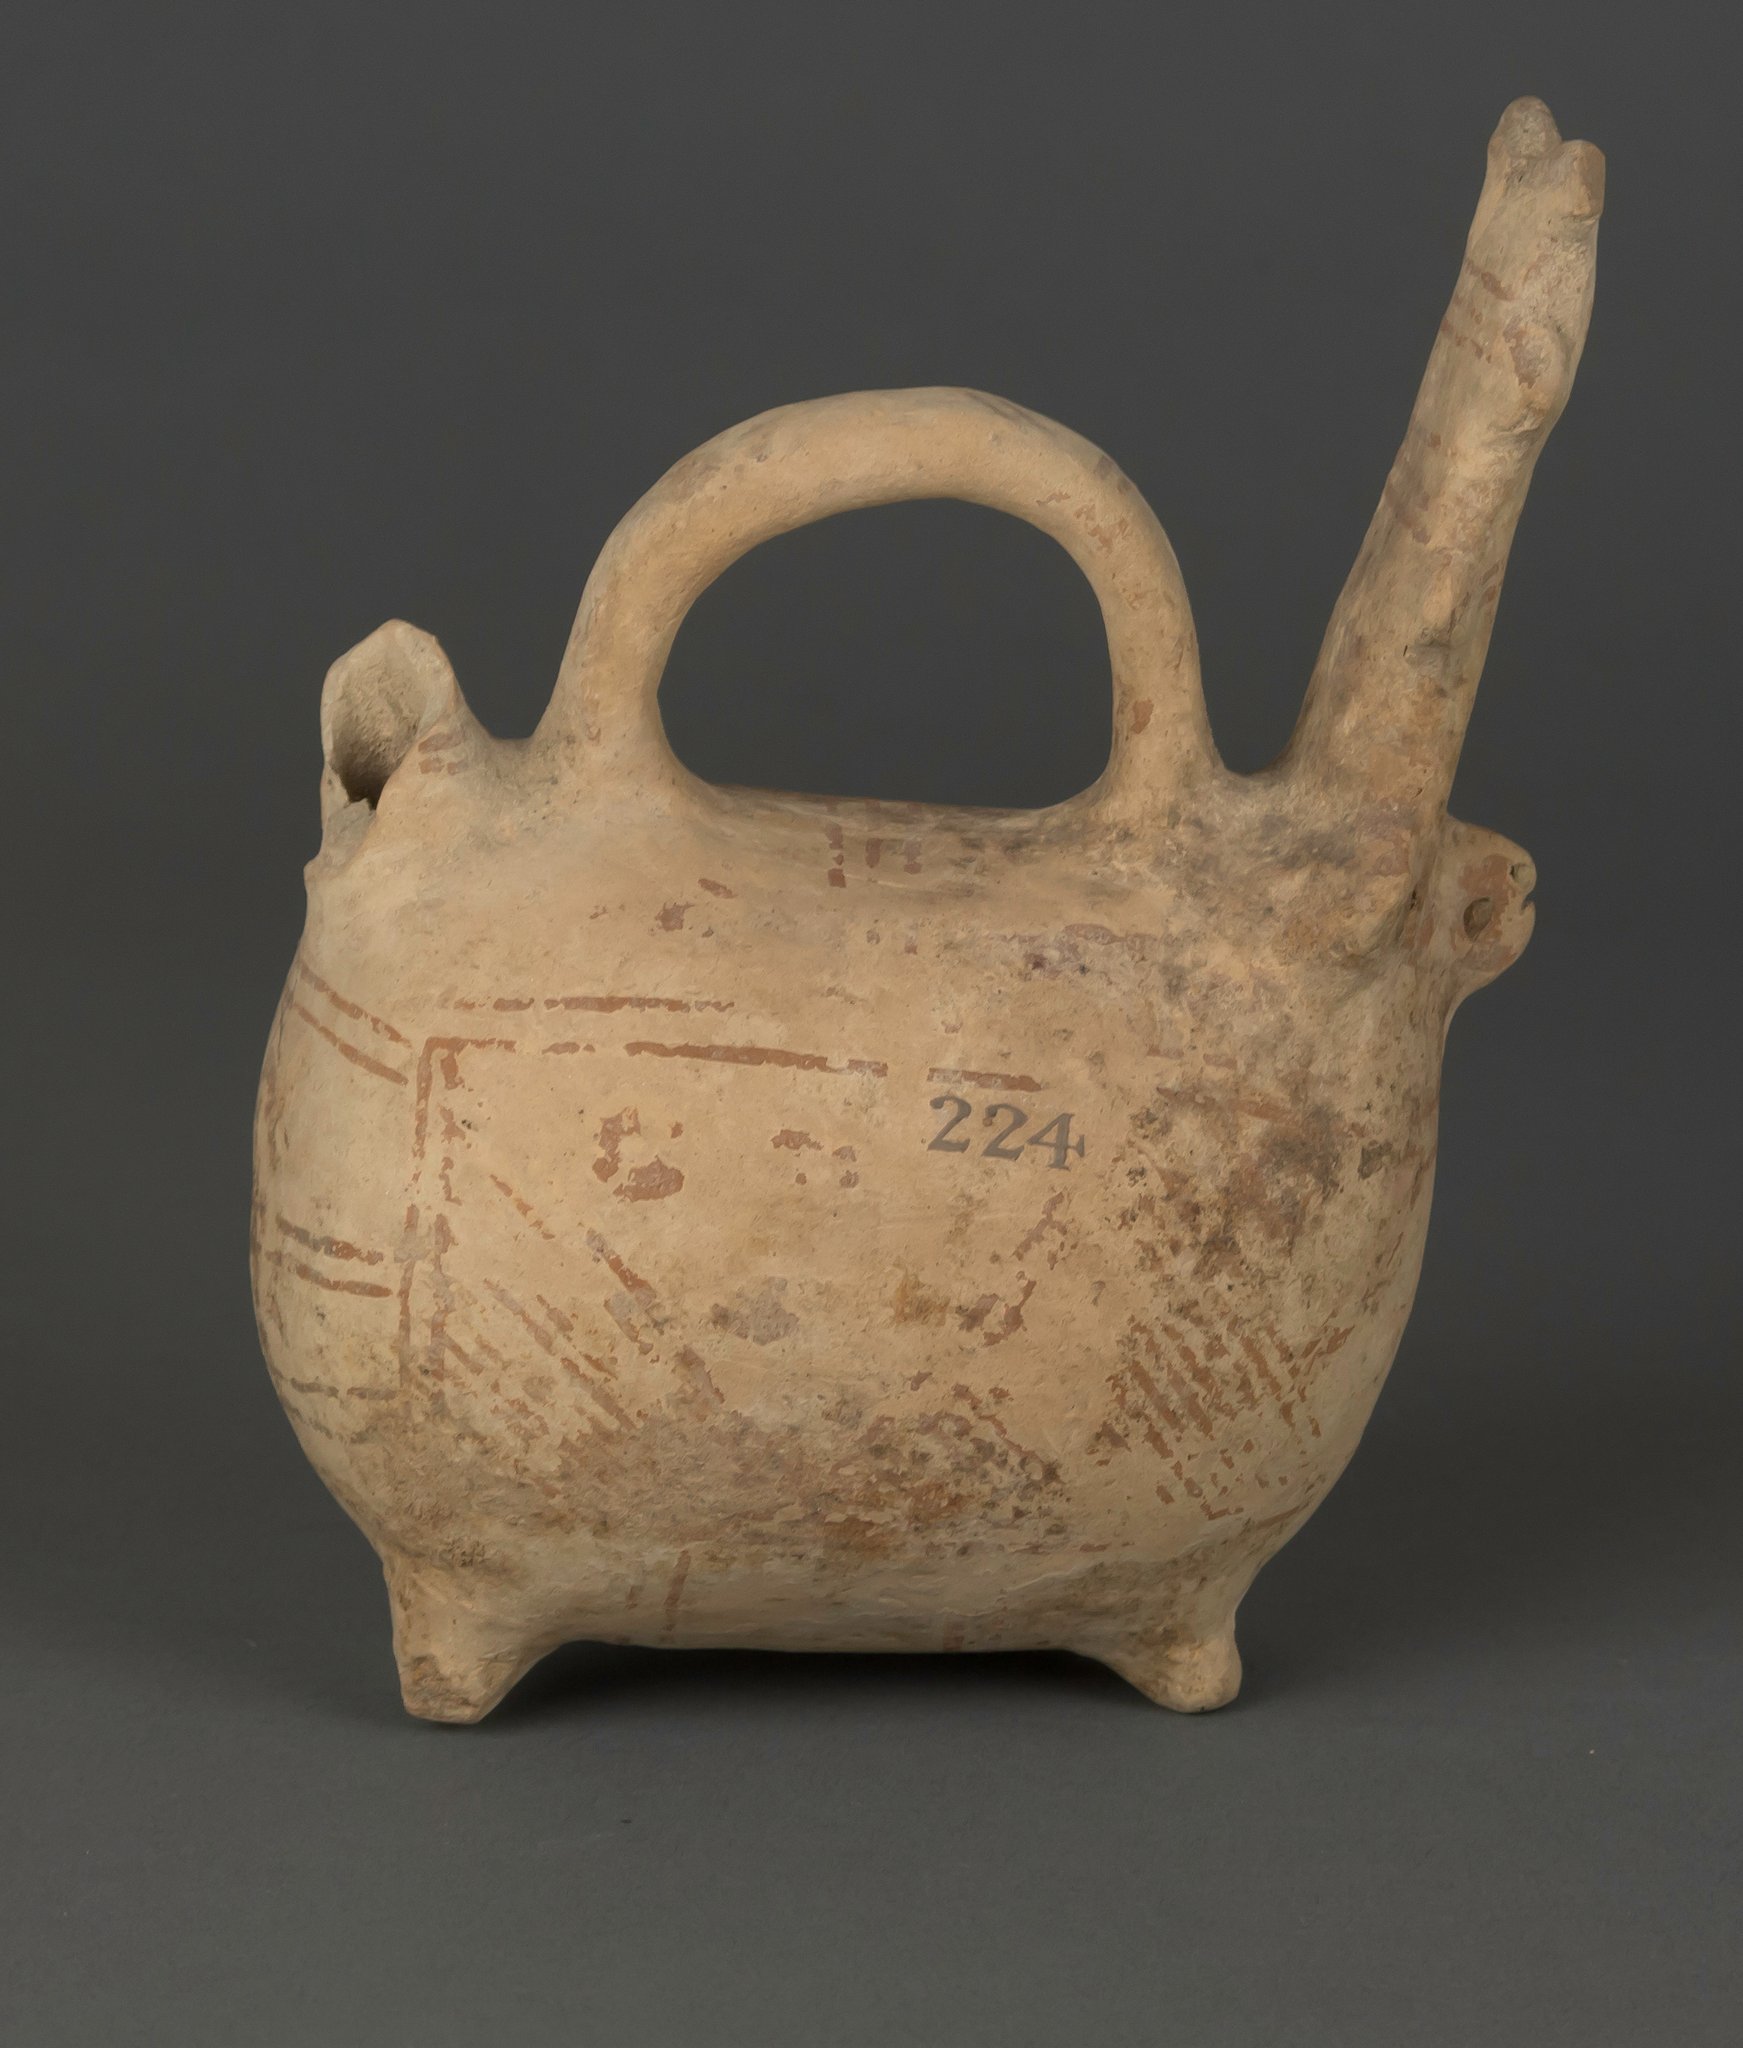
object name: askos in the form of an animal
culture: cypriot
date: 1900-1600 BCE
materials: terracotta